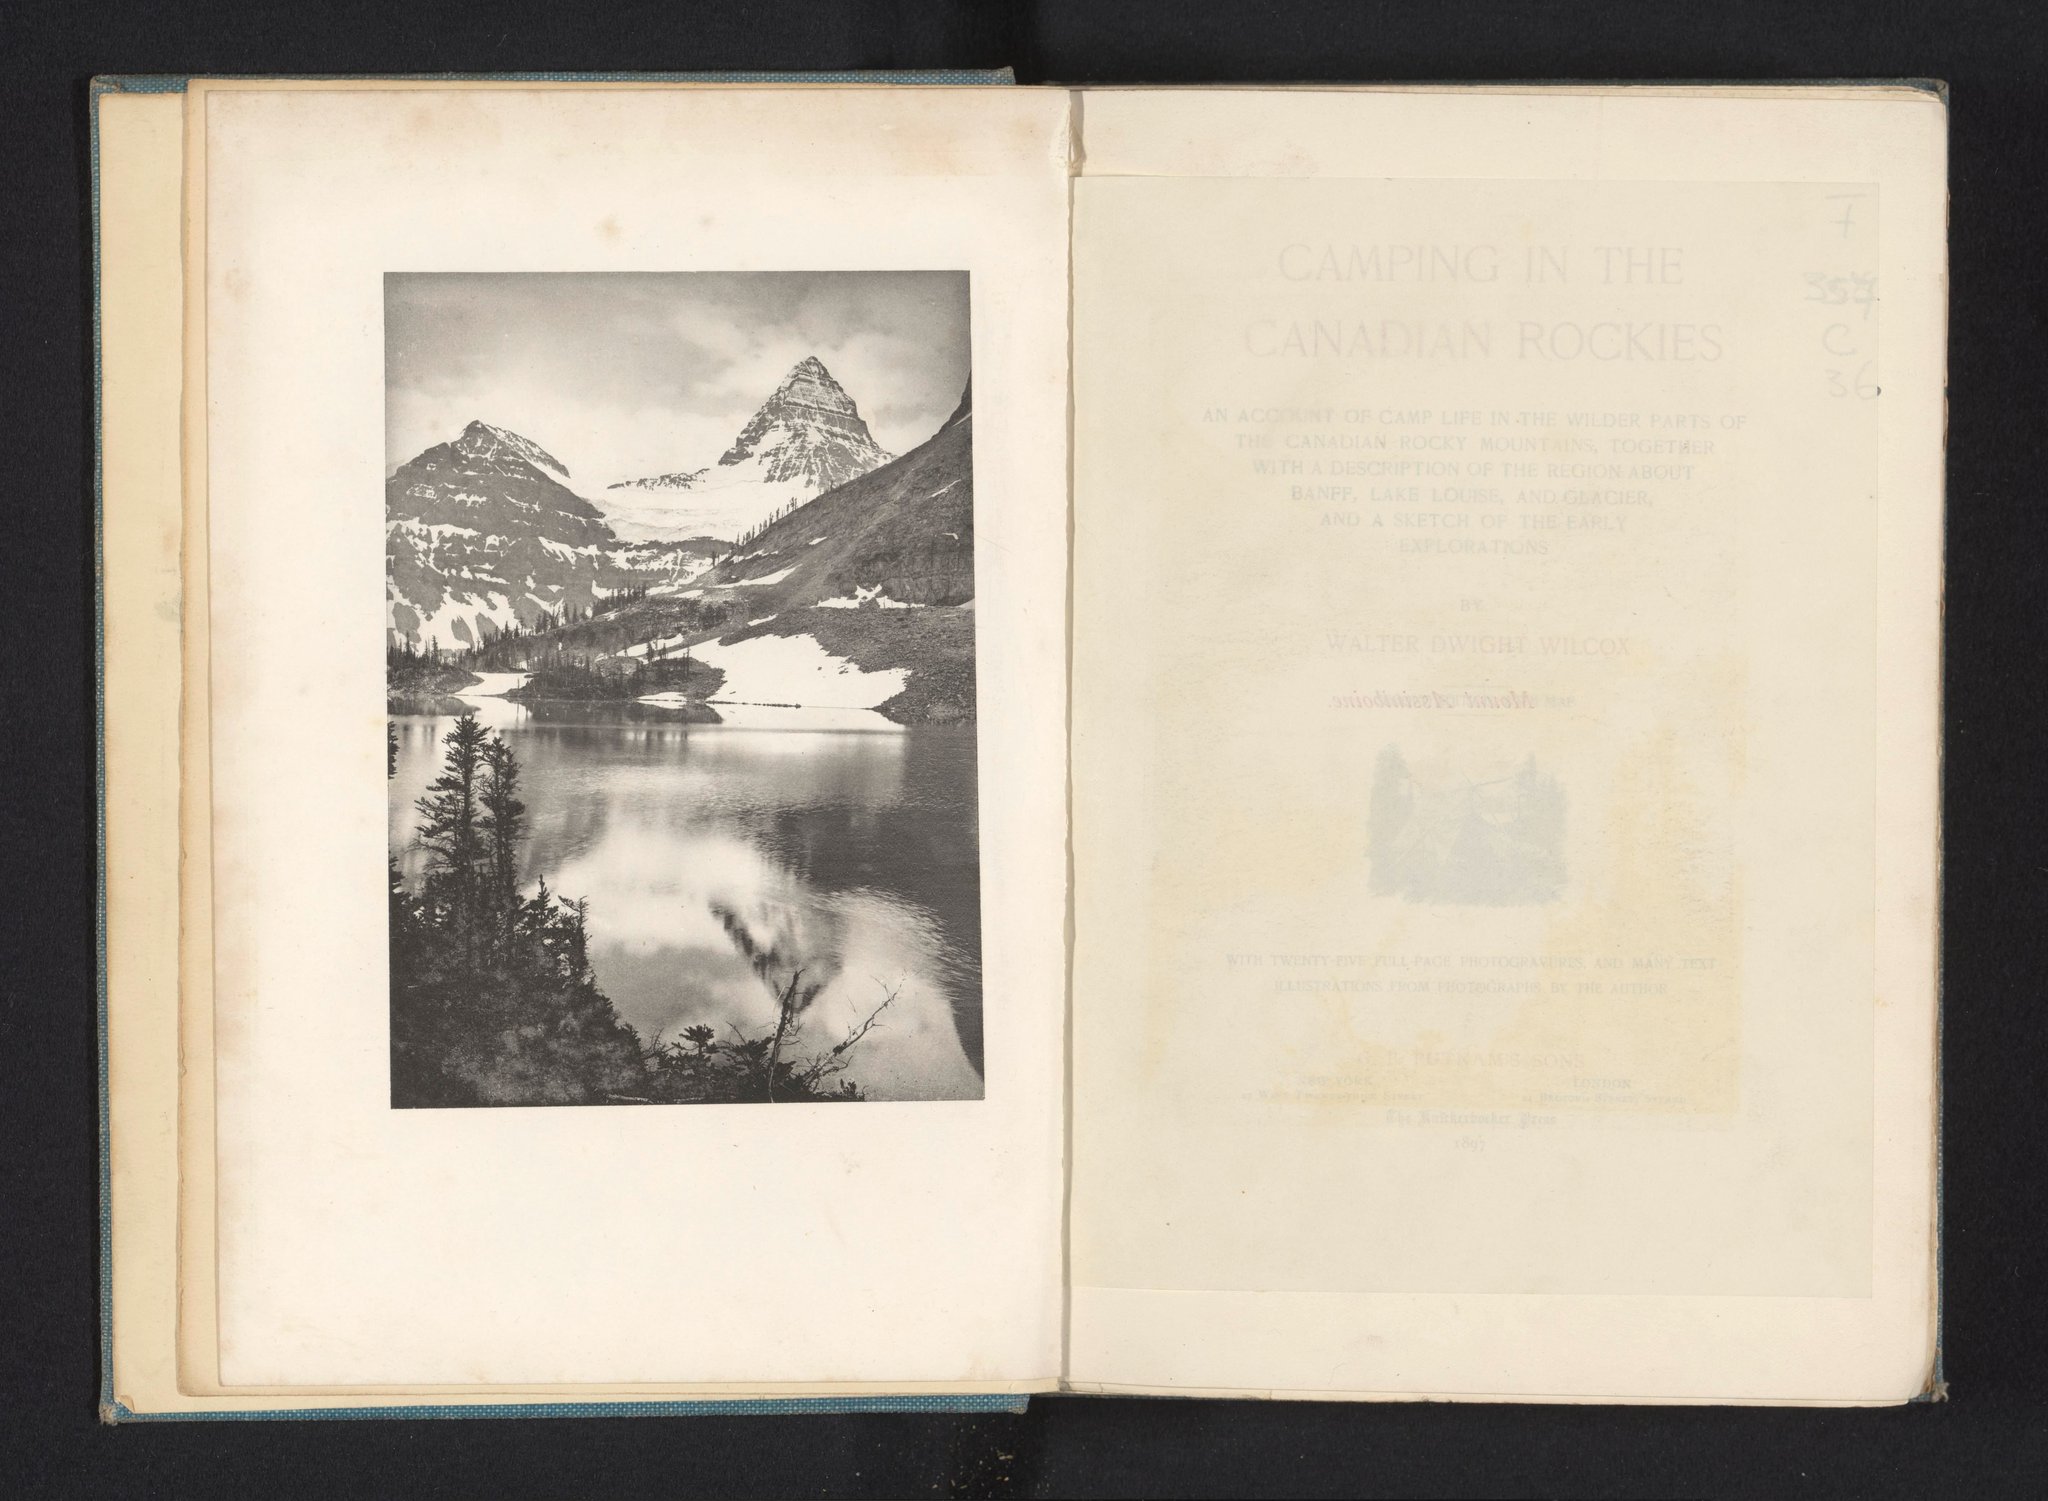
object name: photomechanical print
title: Gezicht op Mount Assiniboine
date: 1893-1897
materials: paper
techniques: photoaquatint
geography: canada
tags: mountains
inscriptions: title: ‘Mount Assiniboine’